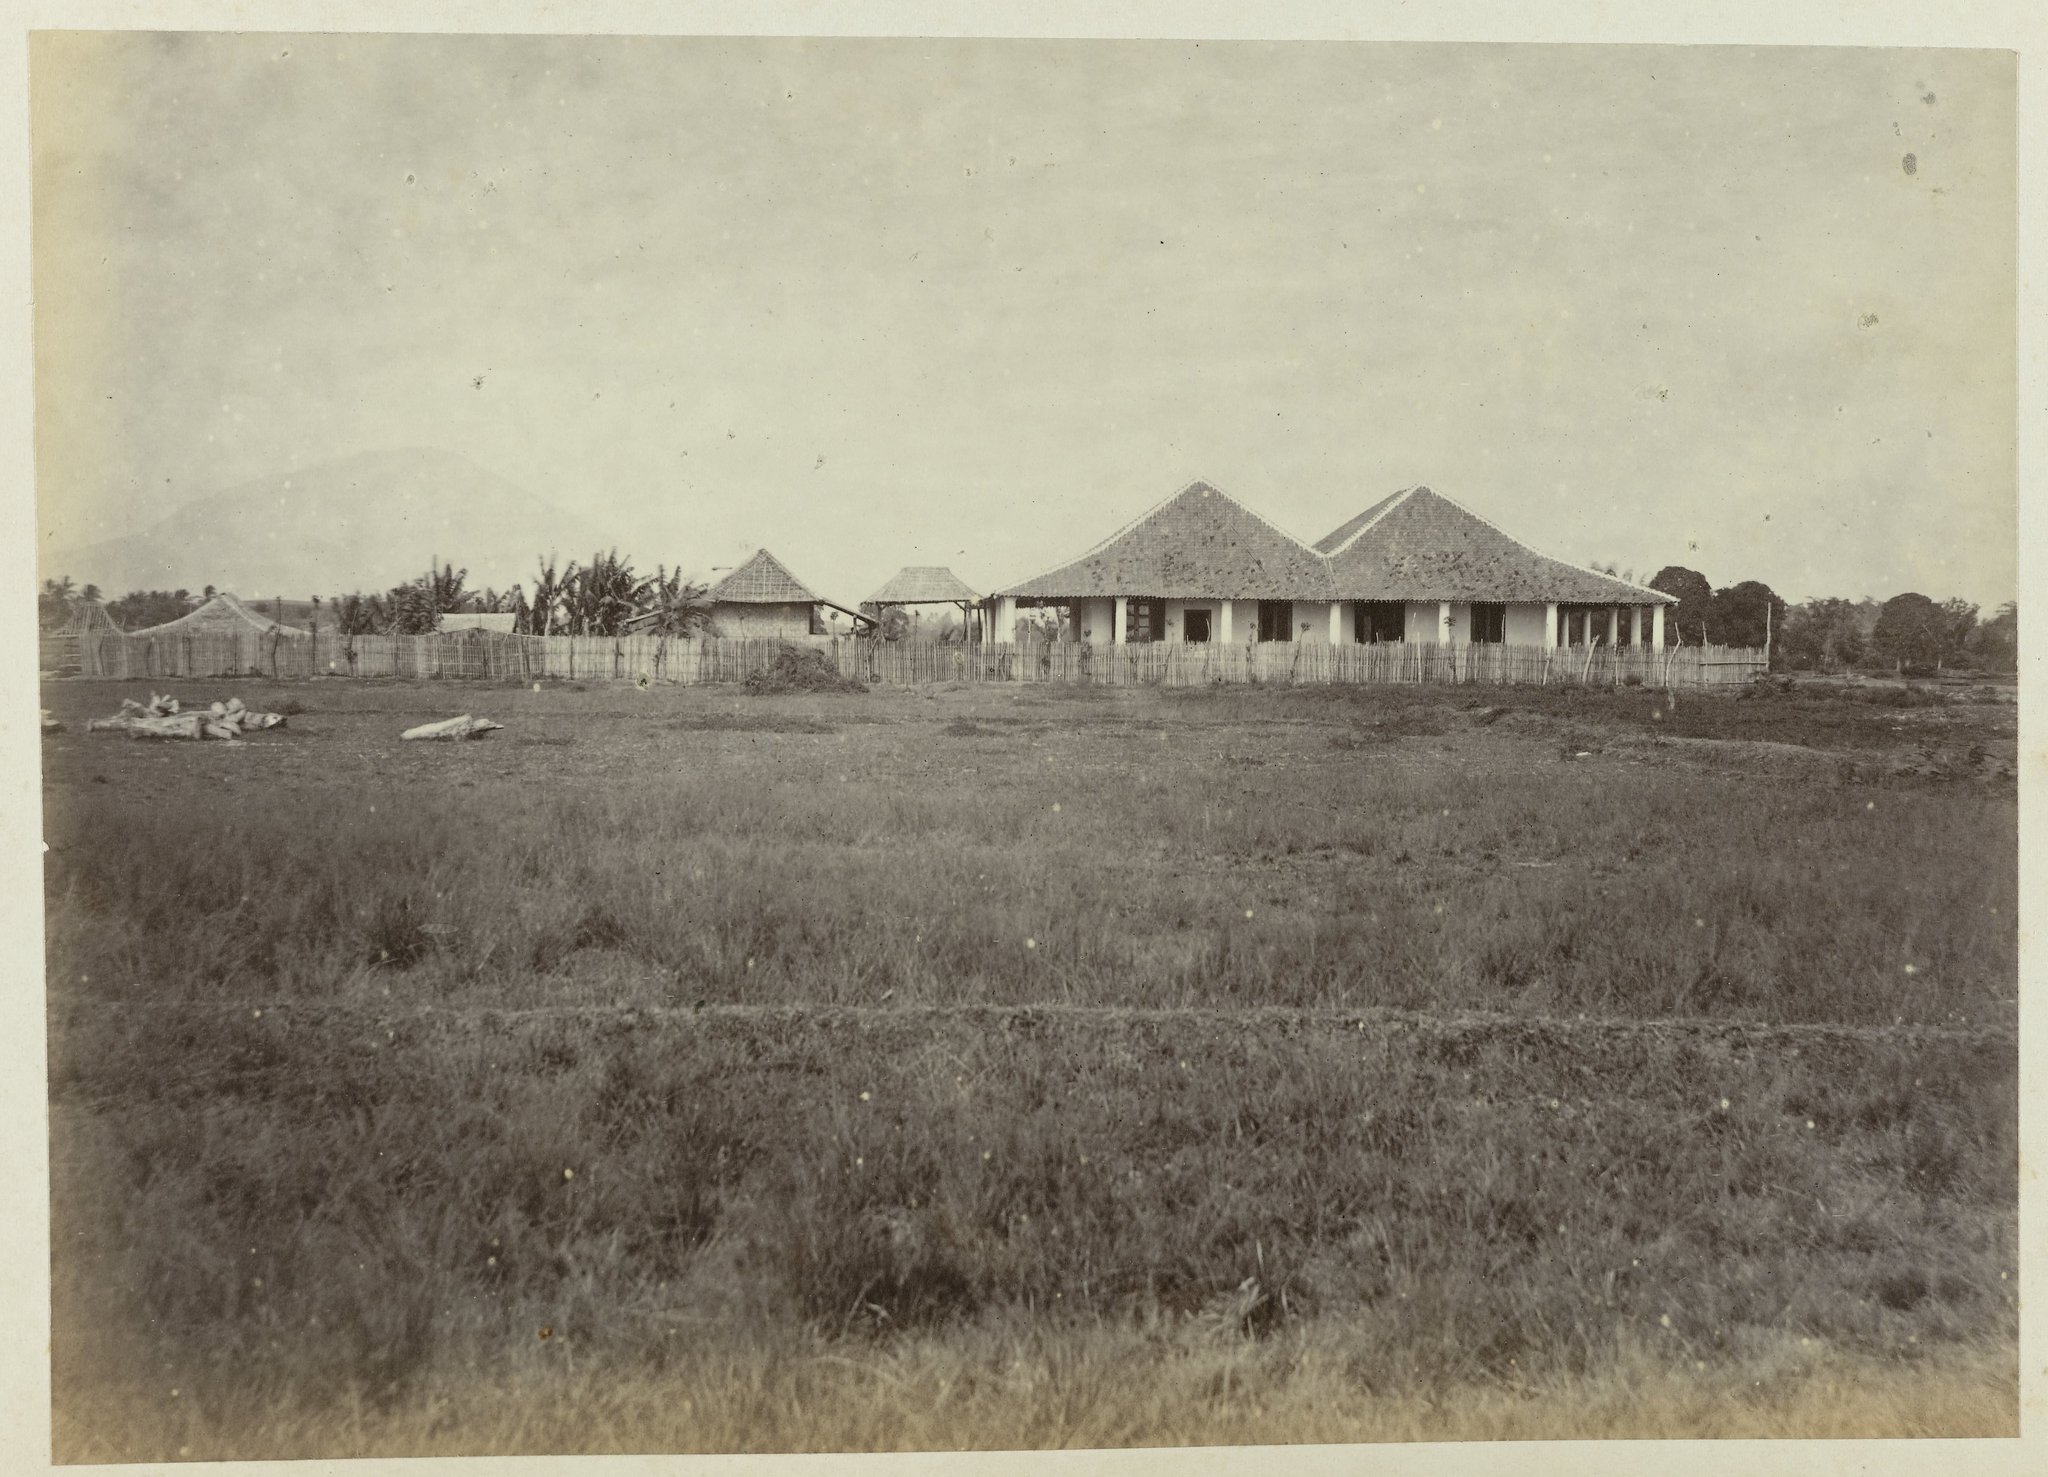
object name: photograph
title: Huizen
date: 1863-1869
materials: photographic support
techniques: albumen print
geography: java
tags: village, java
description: Een groep huizen binnen een omheining. Onderdeel van het groene fotoalbum met foto's van Java, uit het bezit van apotheker Specht-Grijp, die in 1865 vanuit Batavia naar Nederland terugkeerde.